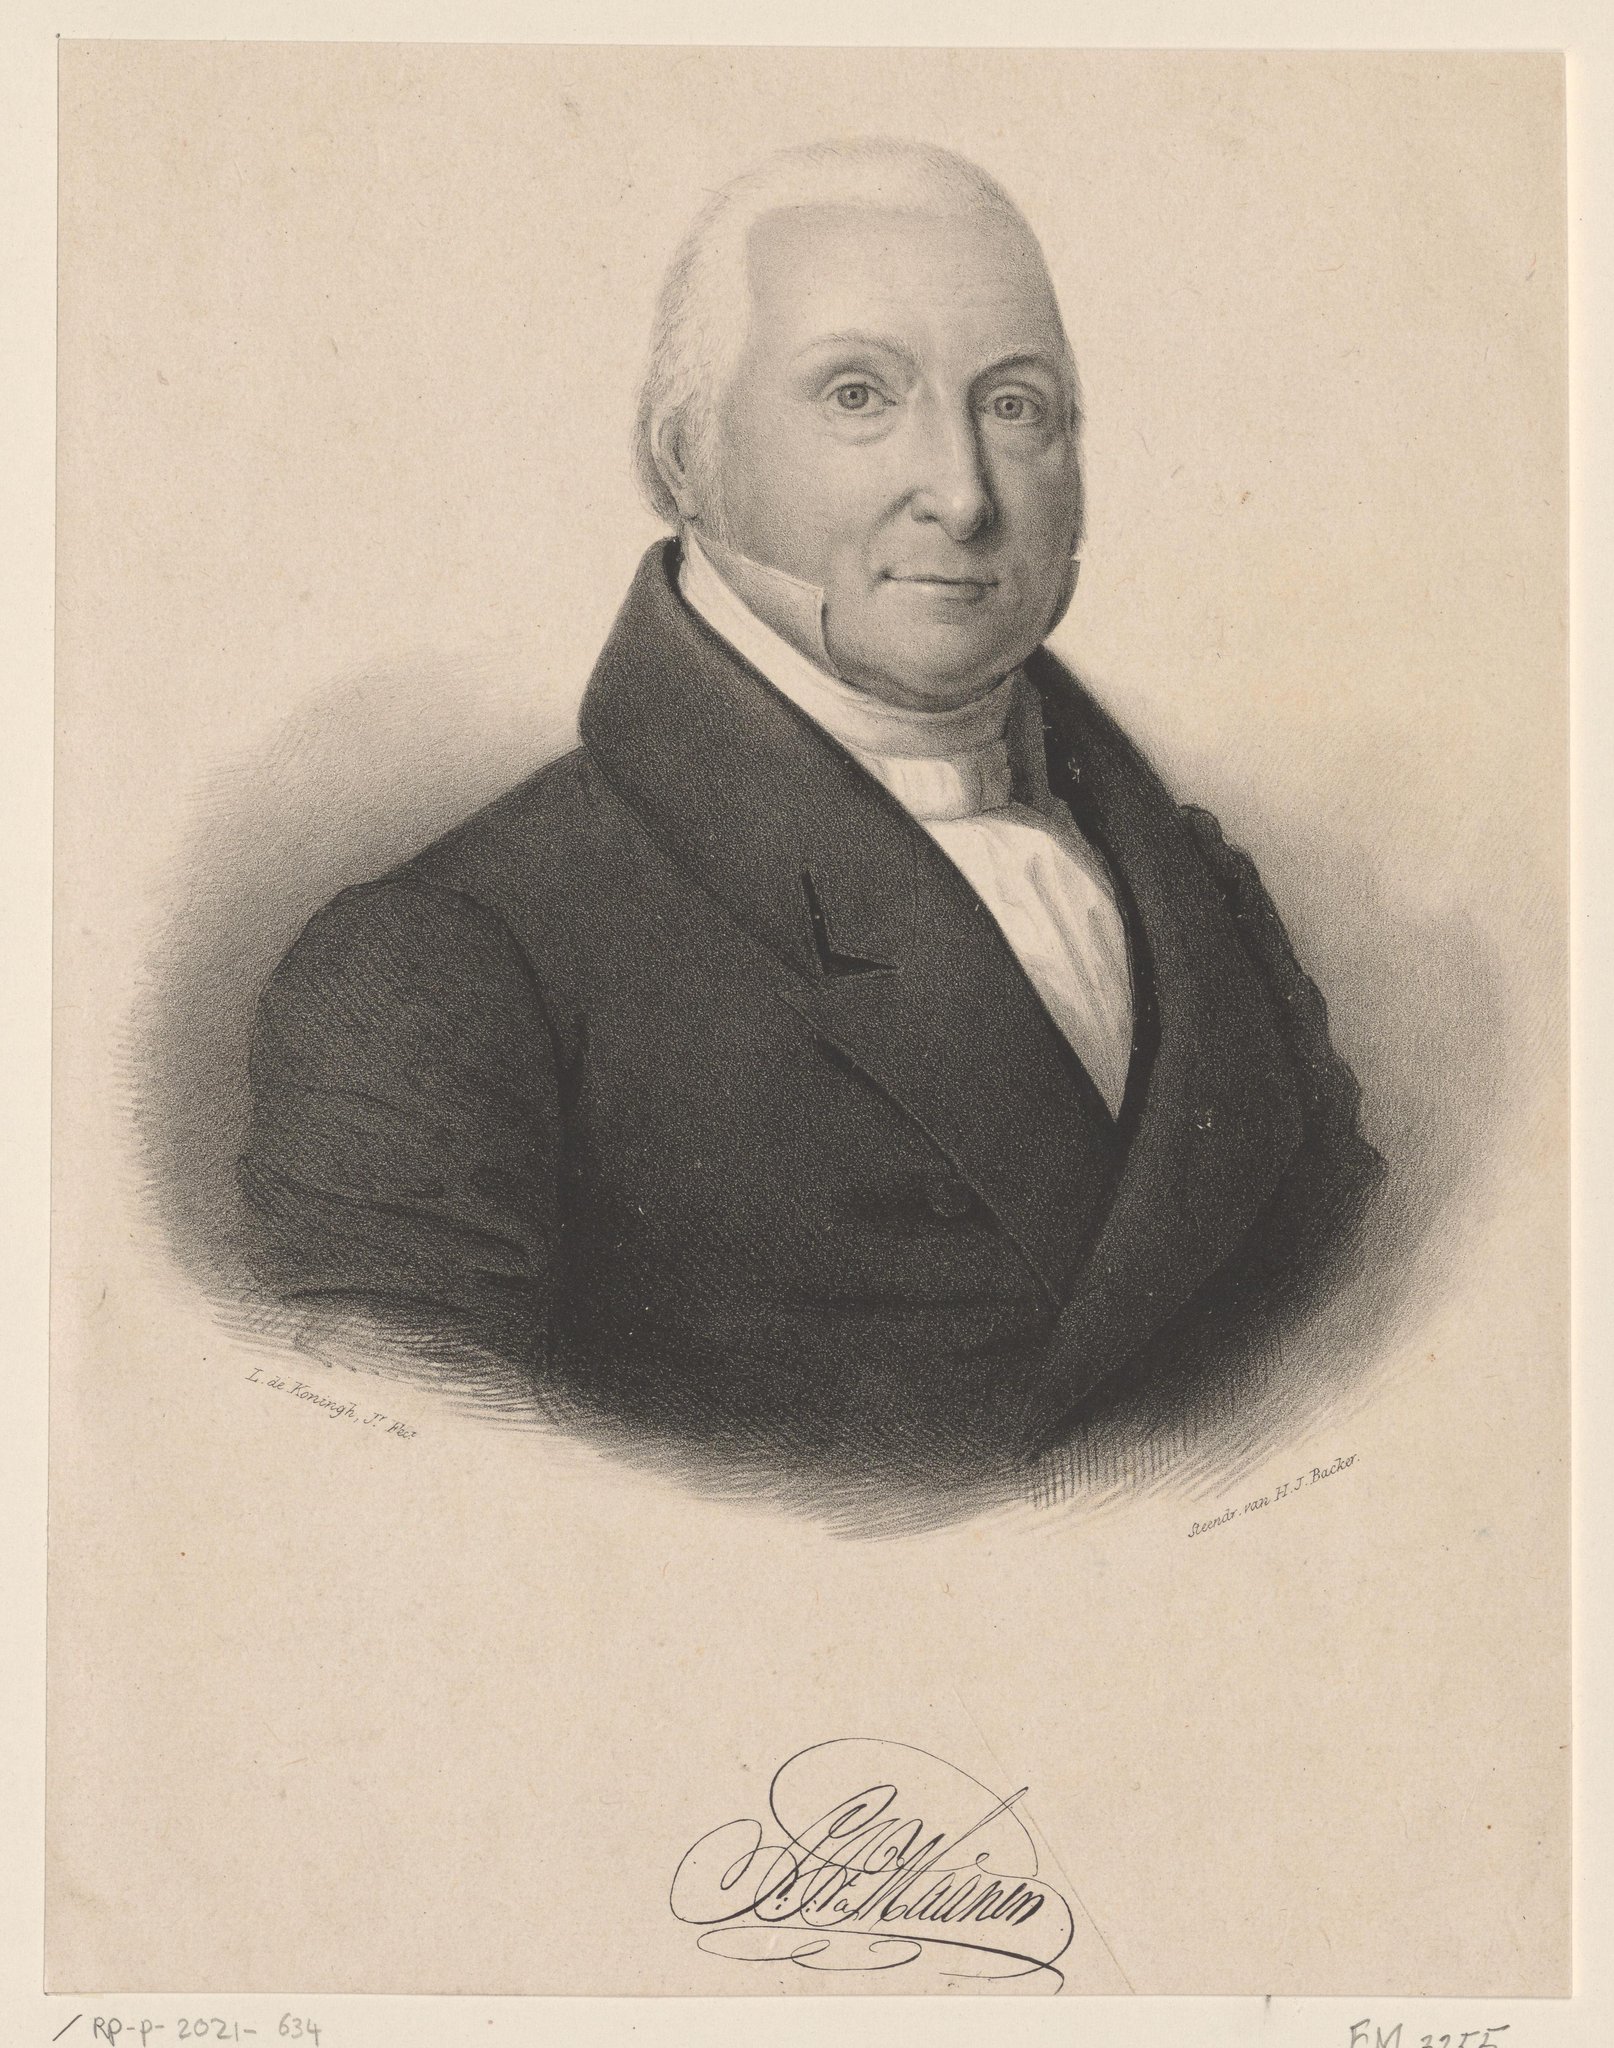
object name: print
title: Portret van Pieter Jacobus van Maanen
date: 1833-1845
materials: paper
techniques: lithograph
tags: the hague, amsterdam, barber; surgeon (+ portrait of scholar, scientist), historical persons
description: Een facsimile signatuur in de ondermarge.